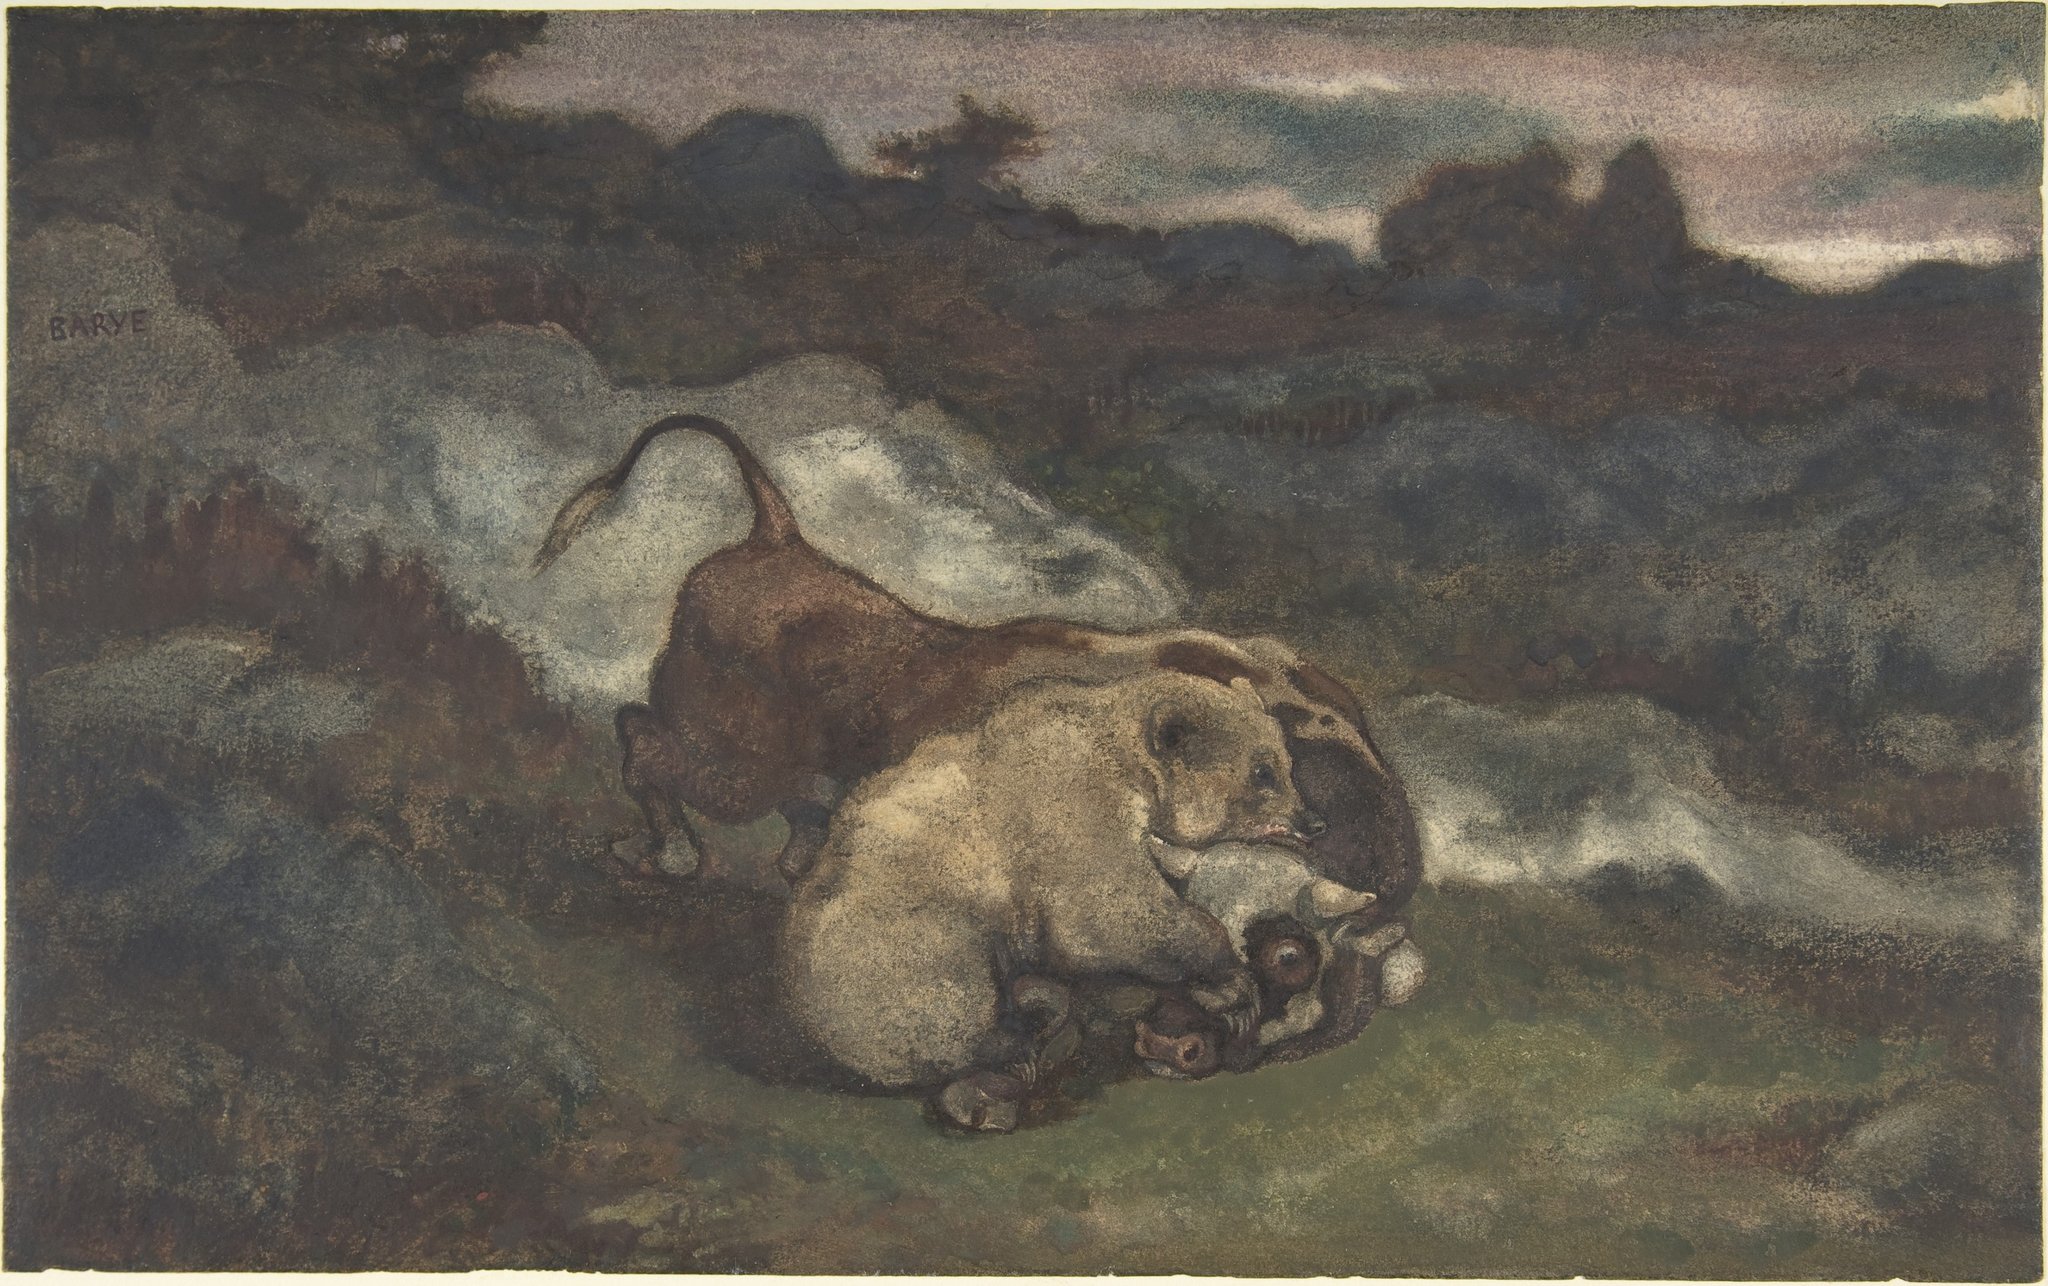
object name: drawing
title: Bear Killing a Bull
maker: antoine-louis barye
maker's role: artist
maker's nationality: french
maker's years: 1795-1875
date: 1810-1875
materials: watercolor, paper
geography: france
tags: bears,hunting,bulls